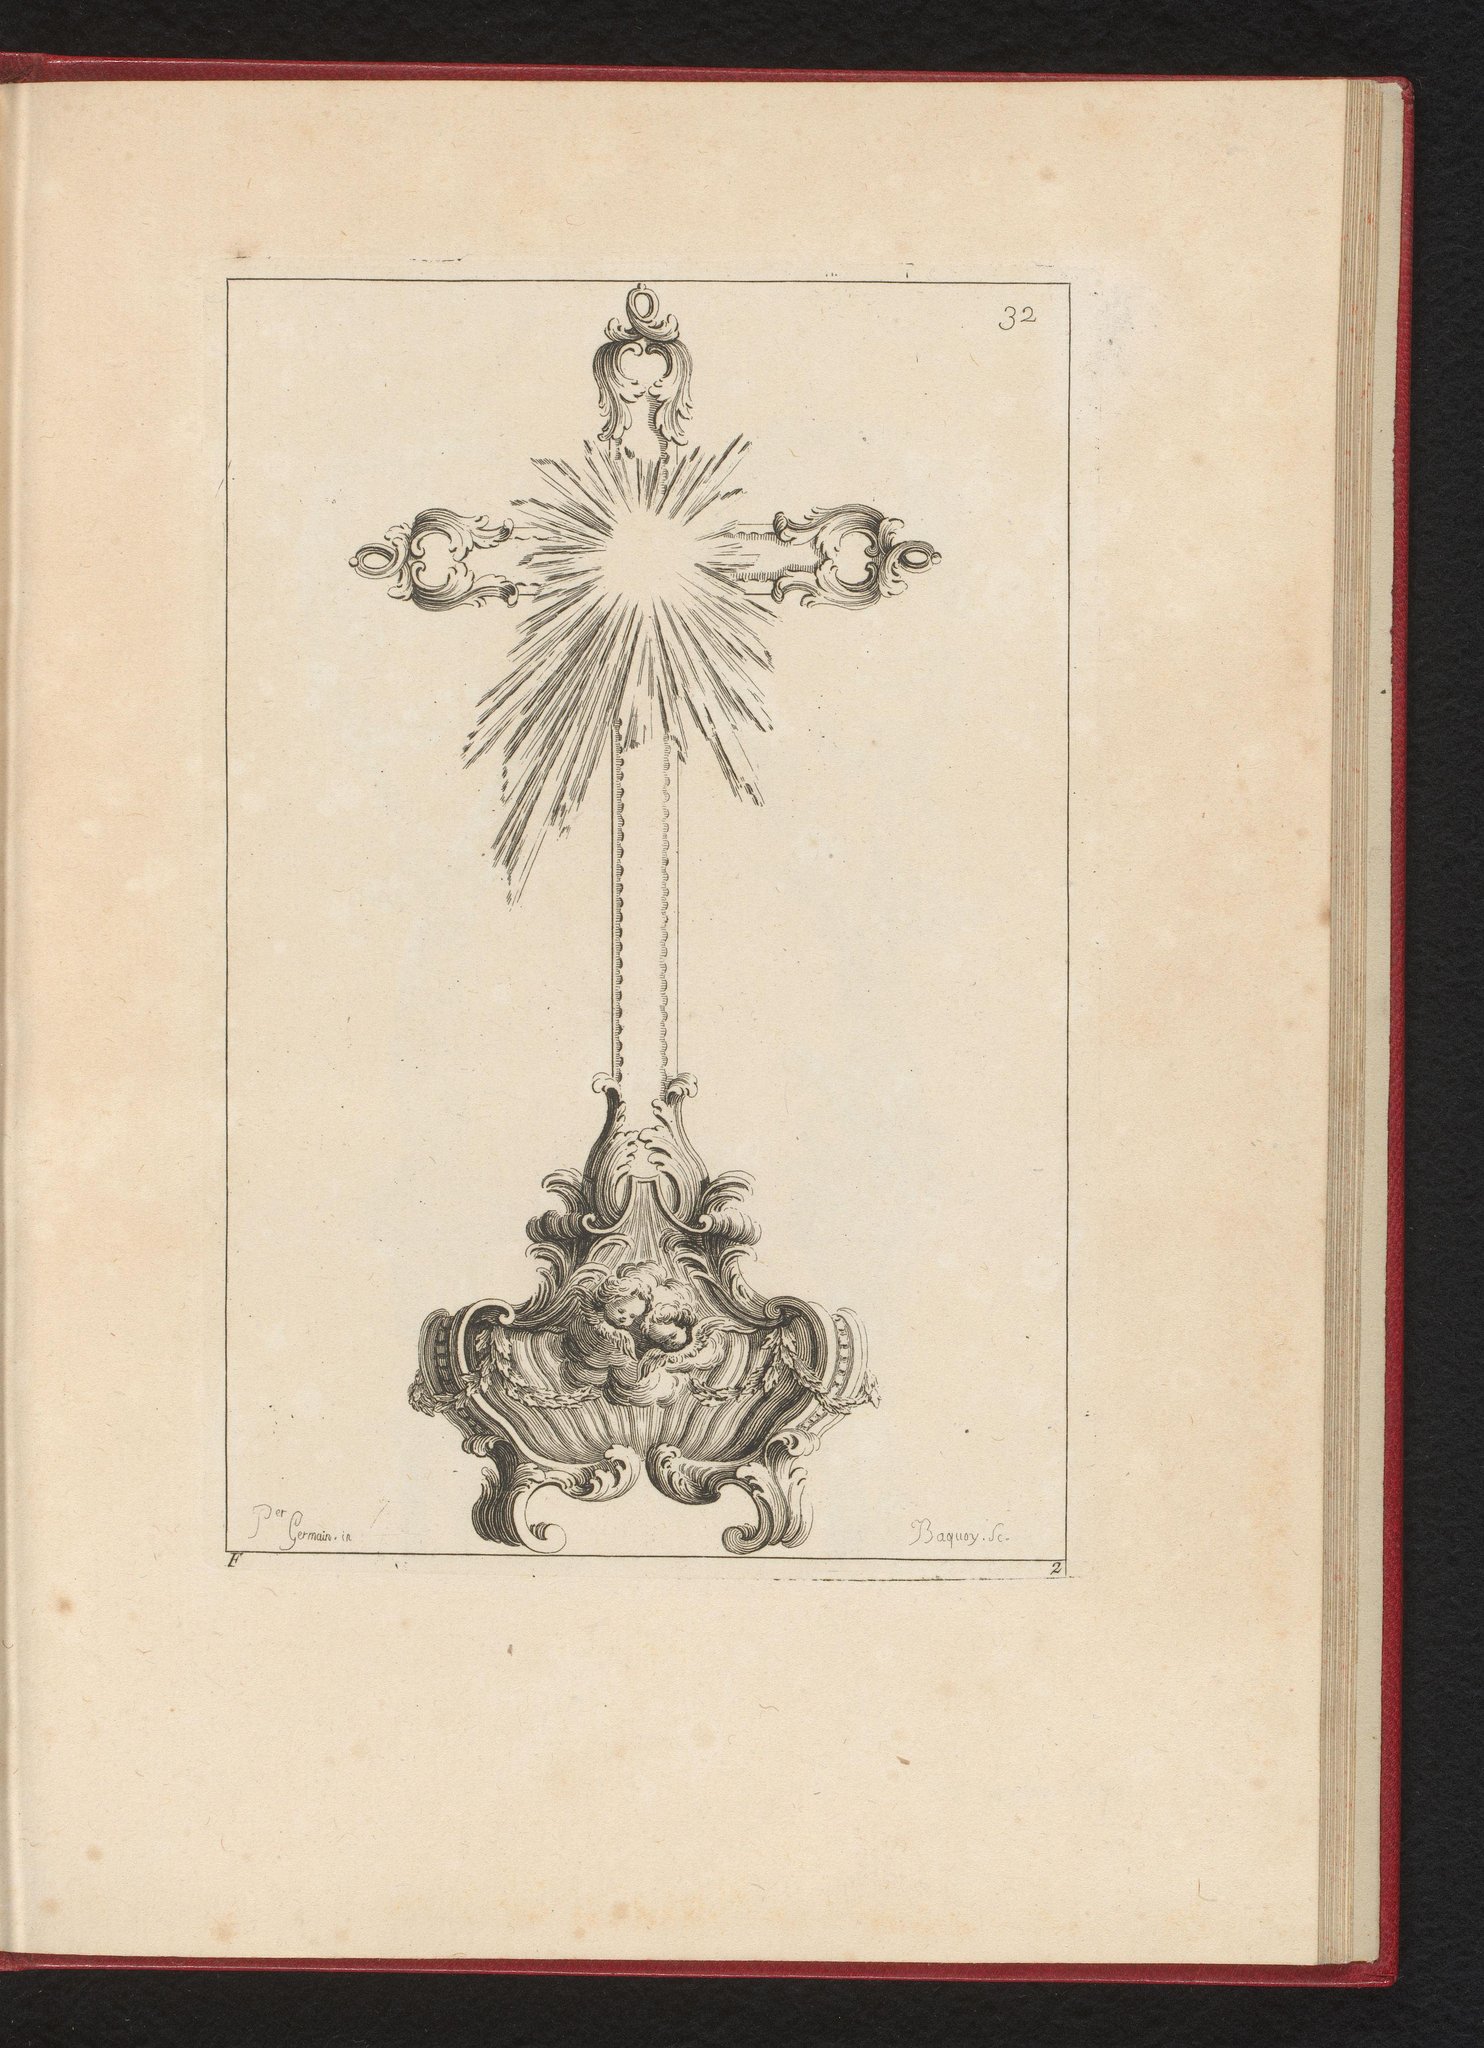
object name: album leaf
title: Elements d'orfevrerie divisés en deux parties de cinquante feuilles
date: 1748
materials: paper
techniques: etching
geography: paris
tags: altarcross, crucifix, jeweller, goldsmith, silversmith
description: Deze prent maakt deel uit van een album.